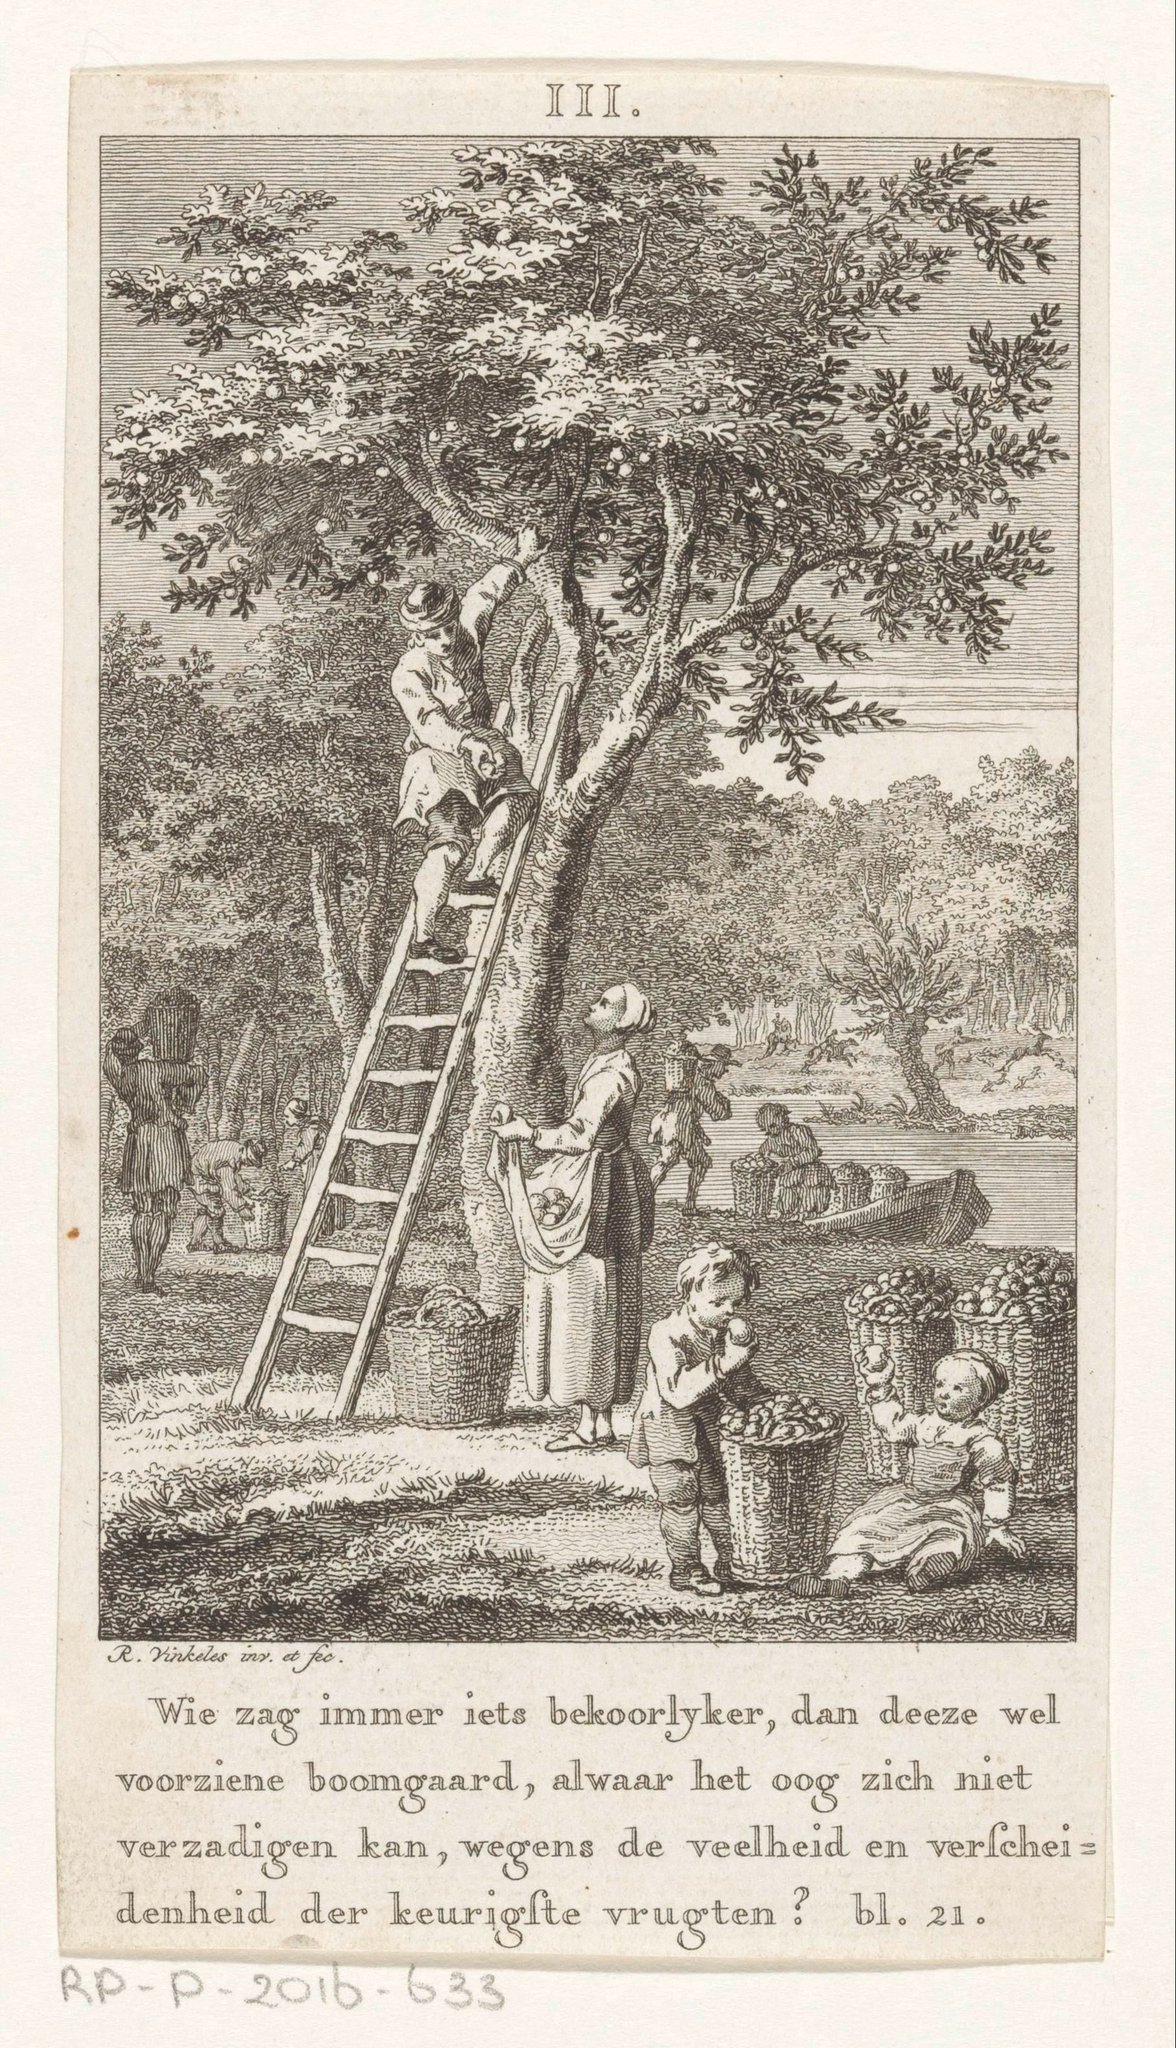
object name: print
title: Herfst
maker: reinier vinkeles (i)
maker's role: draughtsman, print maker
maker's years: 1741-1816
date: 1769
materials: paper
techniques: engraving, etching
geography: amsterdam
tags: autumn ~ human activities (the four seasons of the year), picking fruit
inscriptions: collector's mark: Lugt 2228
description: Prent uit: Engelberts, E.M. Bespiegelingen over de vier getijden des jaars. Amsterdam: Yntema & Tiboel, 1769. Pagina 21. Prent afkomstig uit een plakalbum met titelprenten, ornamenten etc. op blauw papier in 1983 uit elkaar gehaald. Volgens een notitie op verso zat de prent op p. 116 van dit album.